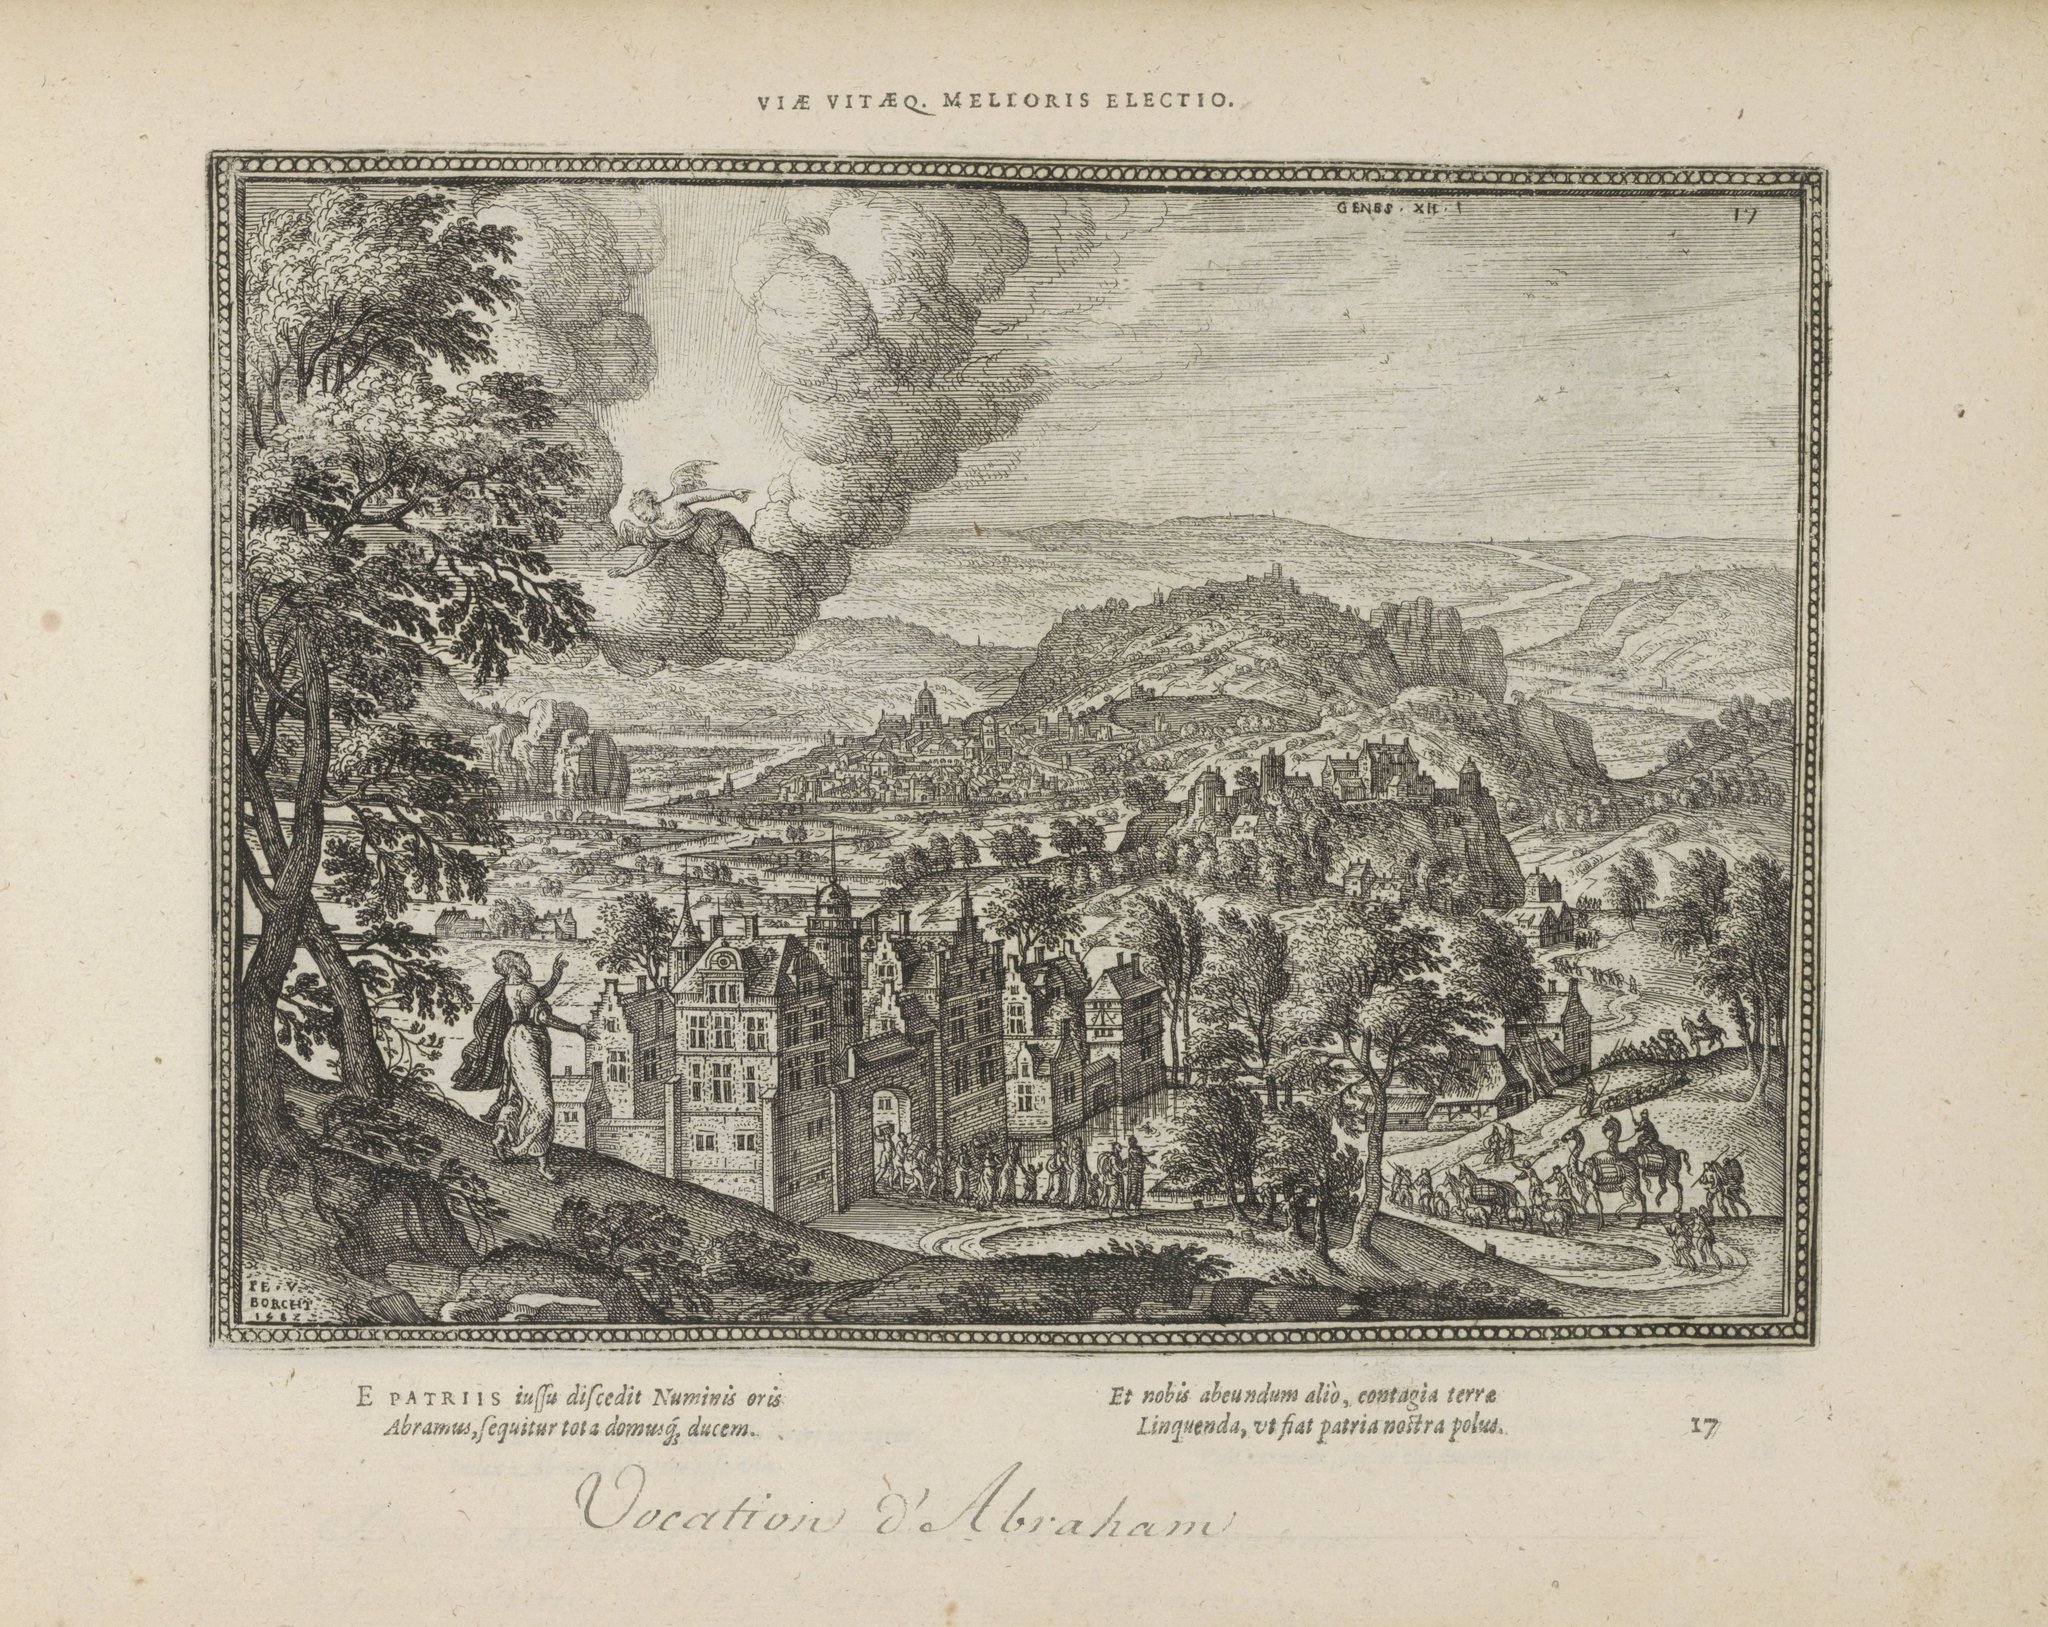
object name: print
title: God verschijnt voor Abraham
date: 1582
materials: paper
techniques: etching, letterpress printing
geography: amsterdam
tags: abraham communicating with god (in general), abraham goes to canaan (genesis 12:1-9)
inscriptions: inscription: ‘Vocation d'Abraham’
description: God in de gedaante van een engel verschijnt voor Abraham en bespreekt met hem het verbond dat hij wil aangaan met zijn volk. Op de achtergrond vertrekt Abraham met zijn familie naar Kanaän (Gen. 12: 1). Met een motto in het Latijn boven de voorstelling en een vierregelig onderschrift in het Latijn onder de prent. De prent maakt deel uit van een album.